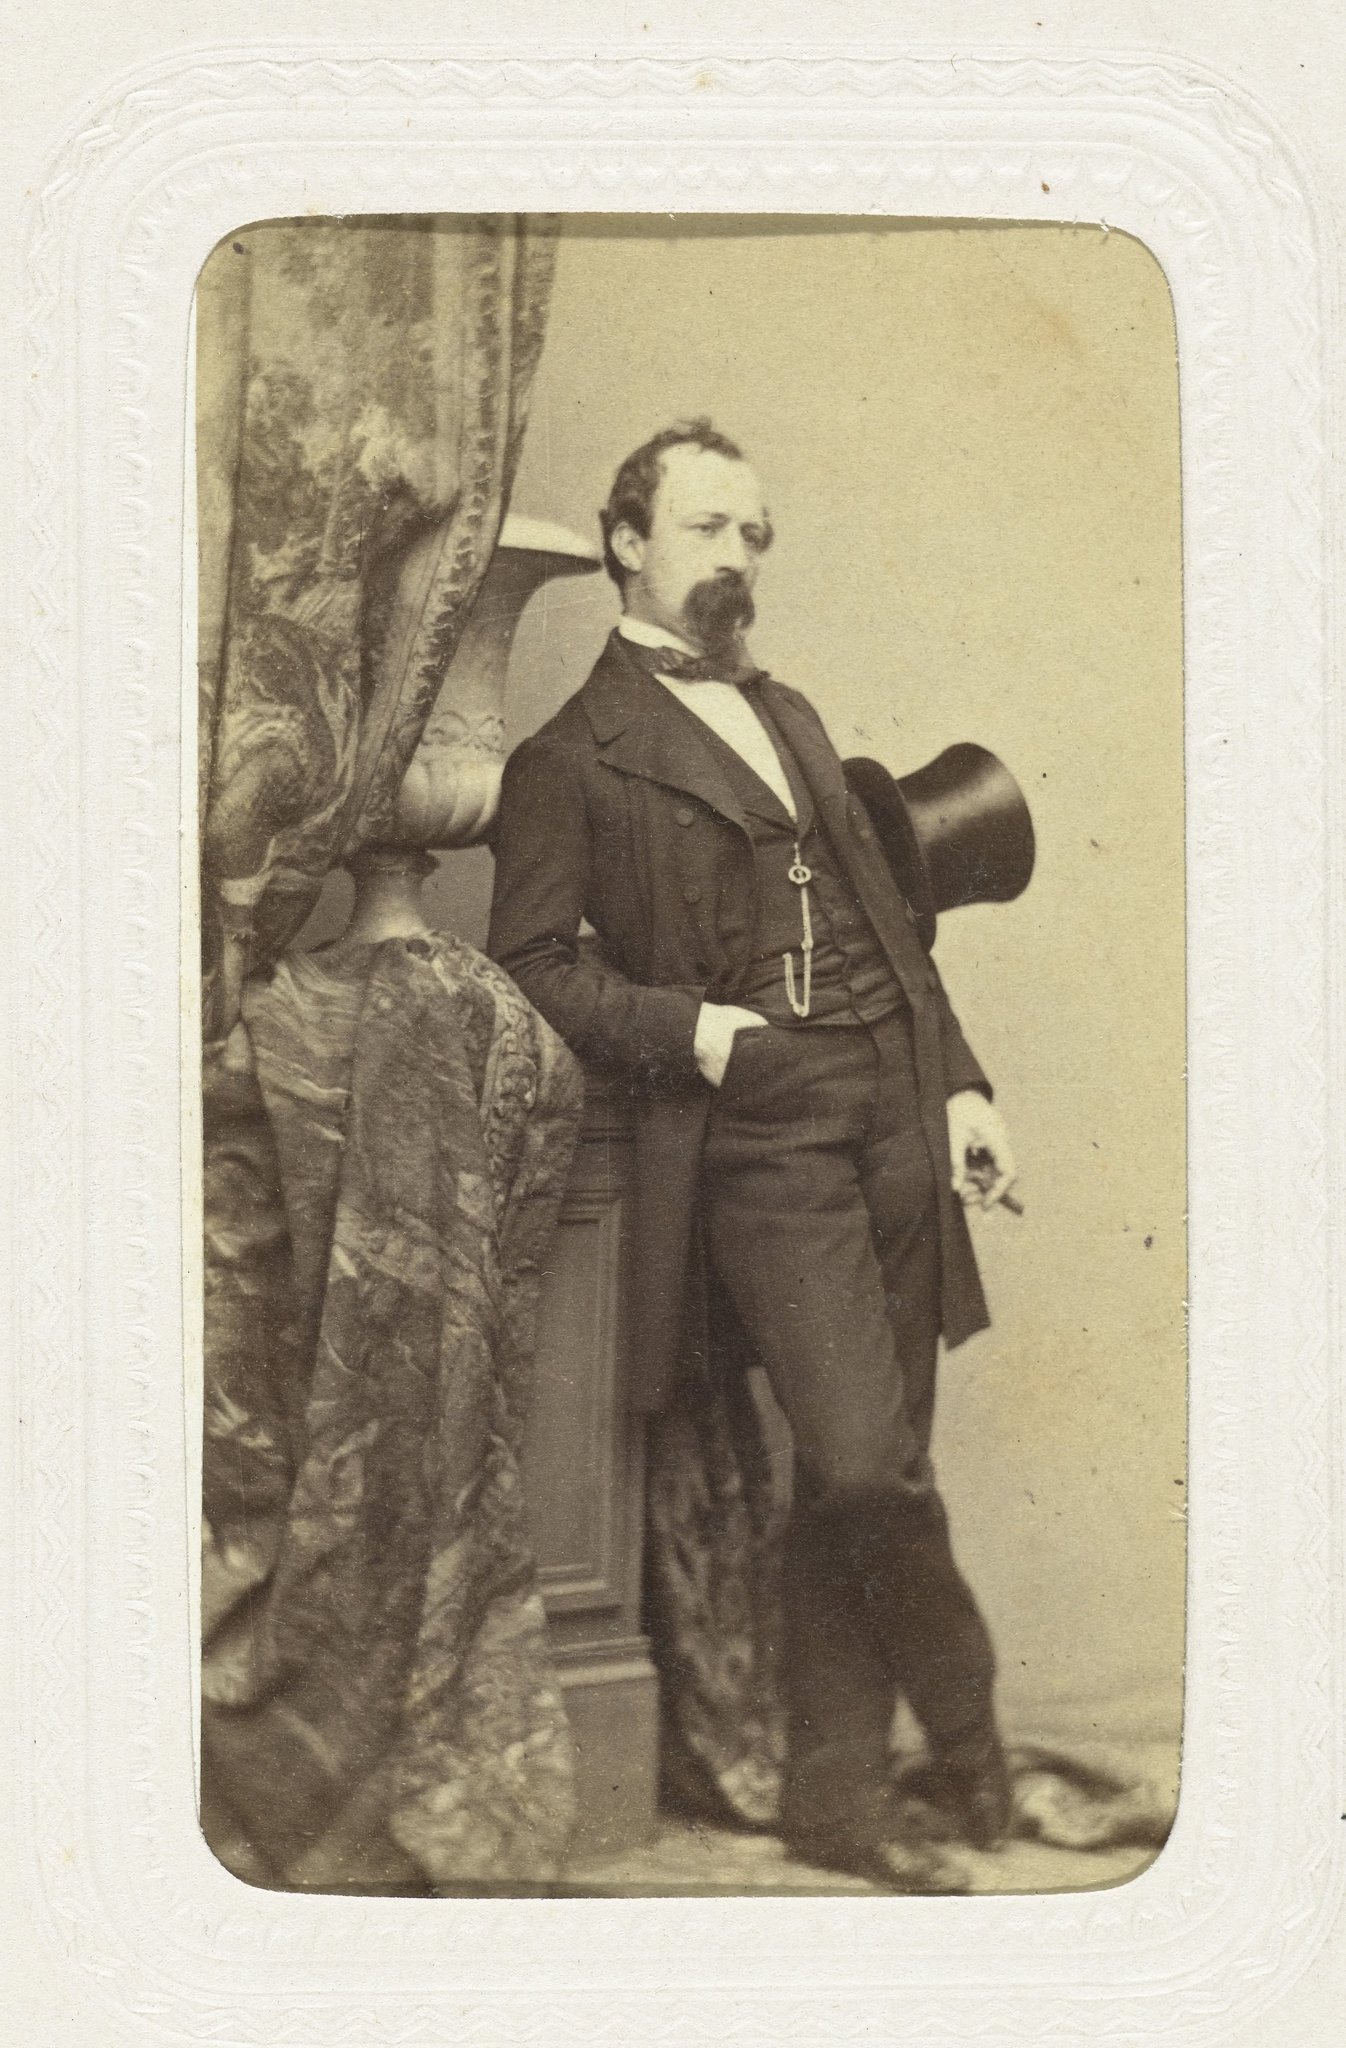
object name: carte de visite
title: Cartes-de-visite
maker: Anonymous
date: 1863-1866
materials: cardboard, paper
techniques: albumen print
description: Cartomanie was a collecting craze. From 1855 hundreds of thousands of these portraits were annually sold worldwide. People had photographs taken of their loved ones, including their pets, and kept them in an album. Portraits of kings, writers, artists, actors, and statesmen were also collected. Photography was no longer the preserve of the wealthy; farmers and maidservants now also stood before the camera.